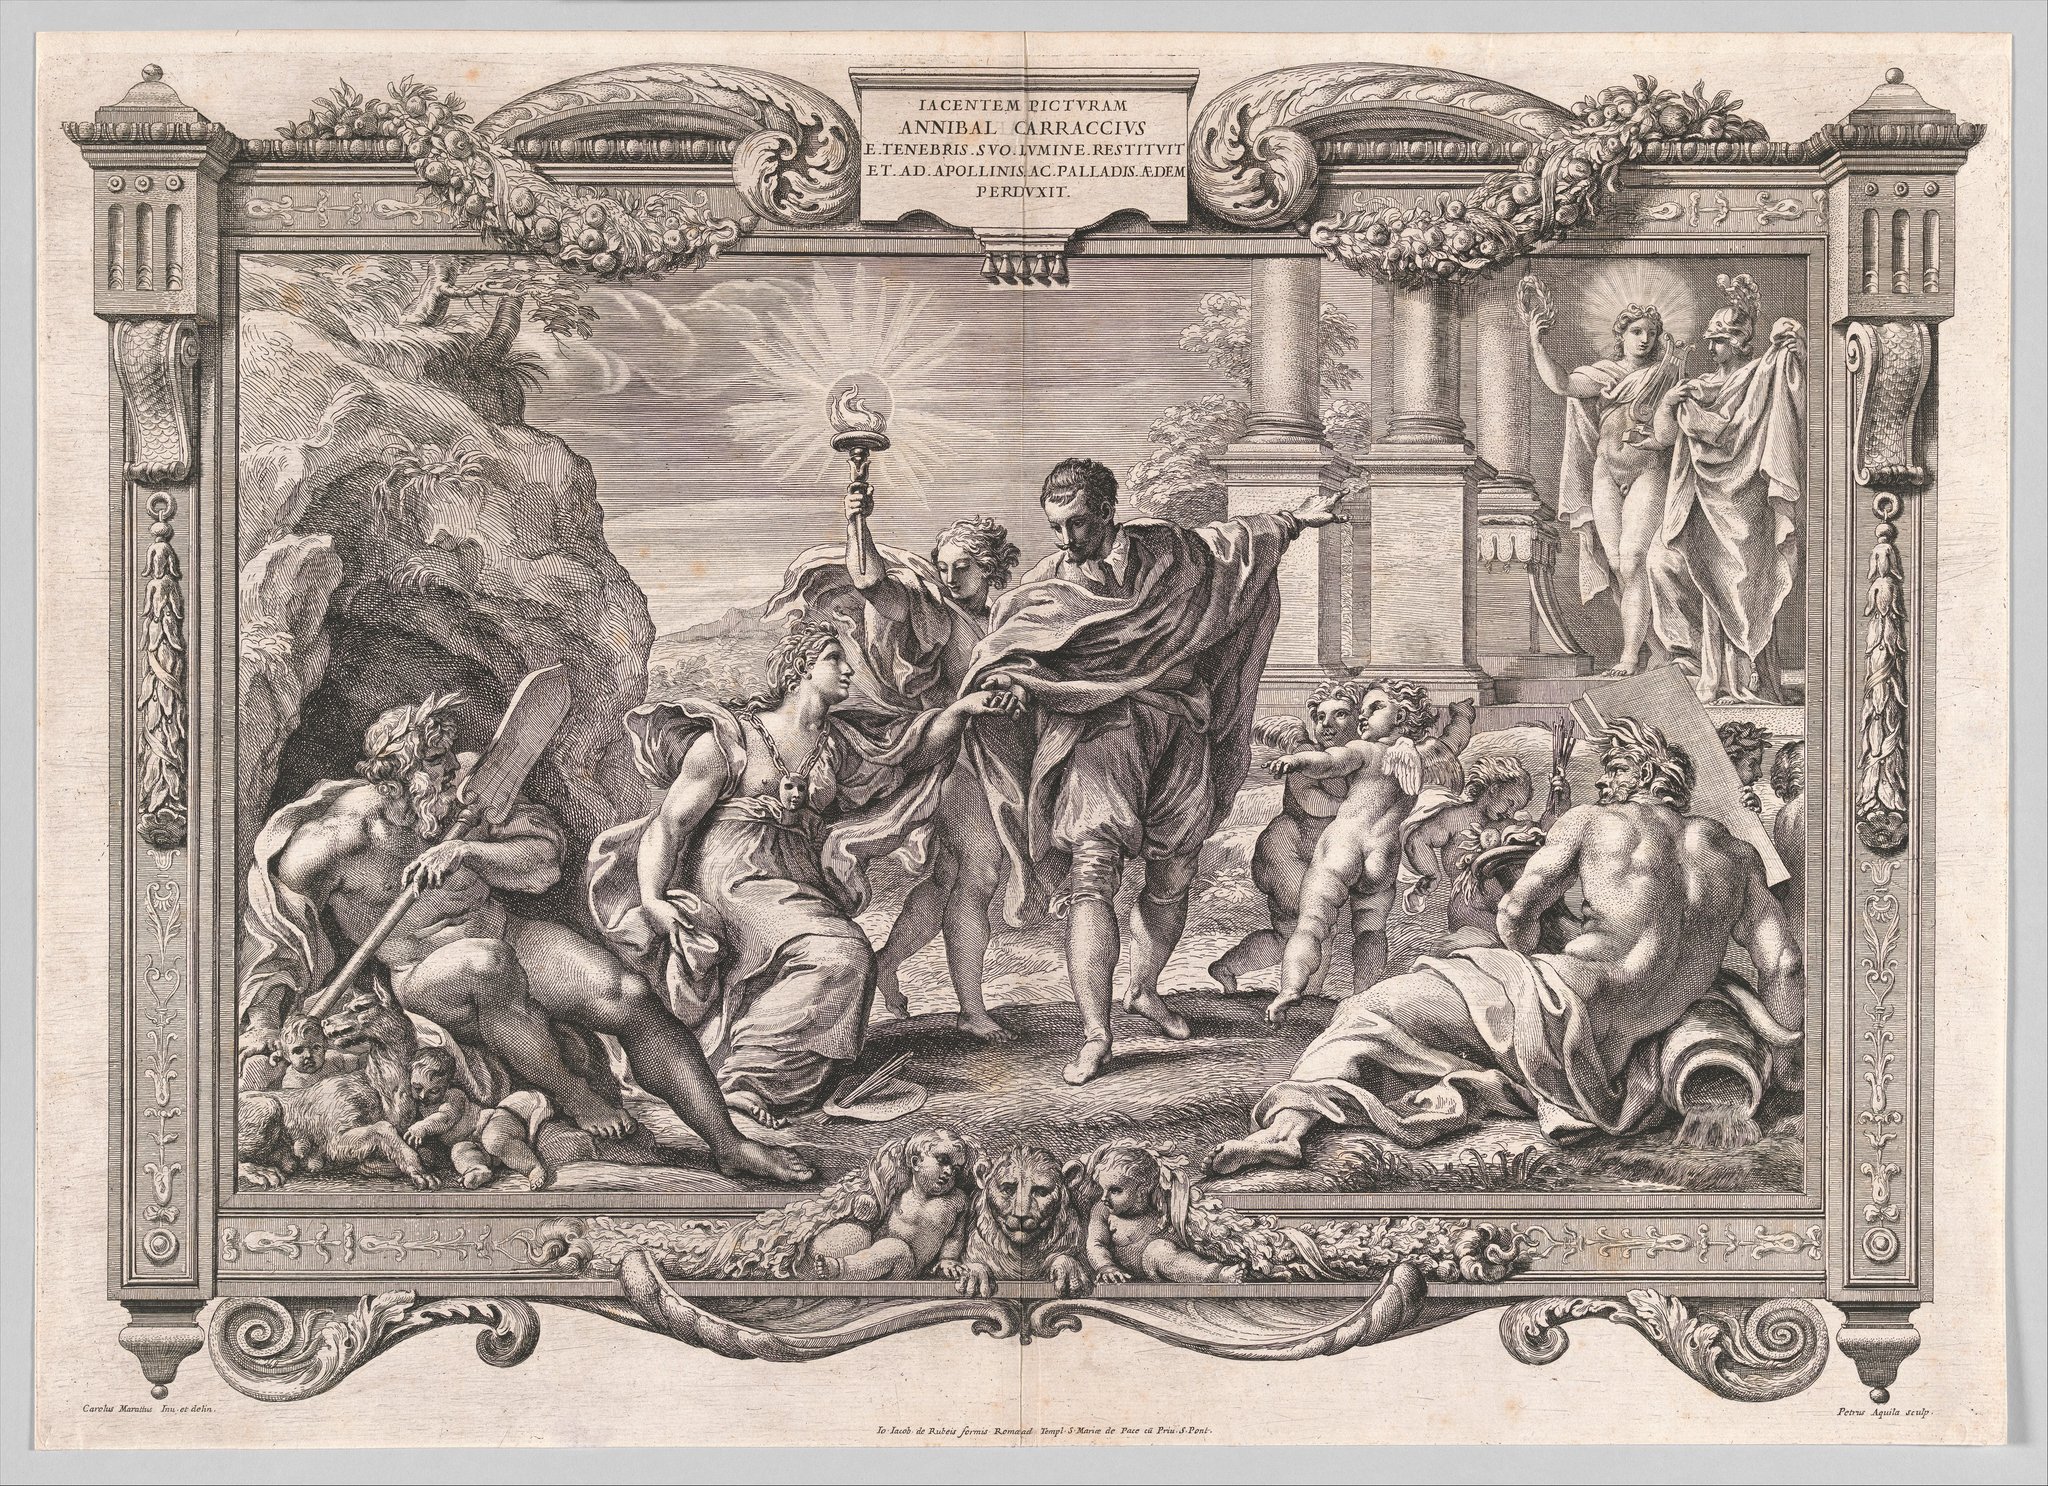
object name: print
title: Annibale Carracci Introduces Painting to Apollo and Minerva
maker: pietro aquila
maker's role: artist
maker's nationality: italian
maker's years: 1650-1700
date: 1674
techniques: engraving, etching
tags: men,women,apollo,putti,minerva